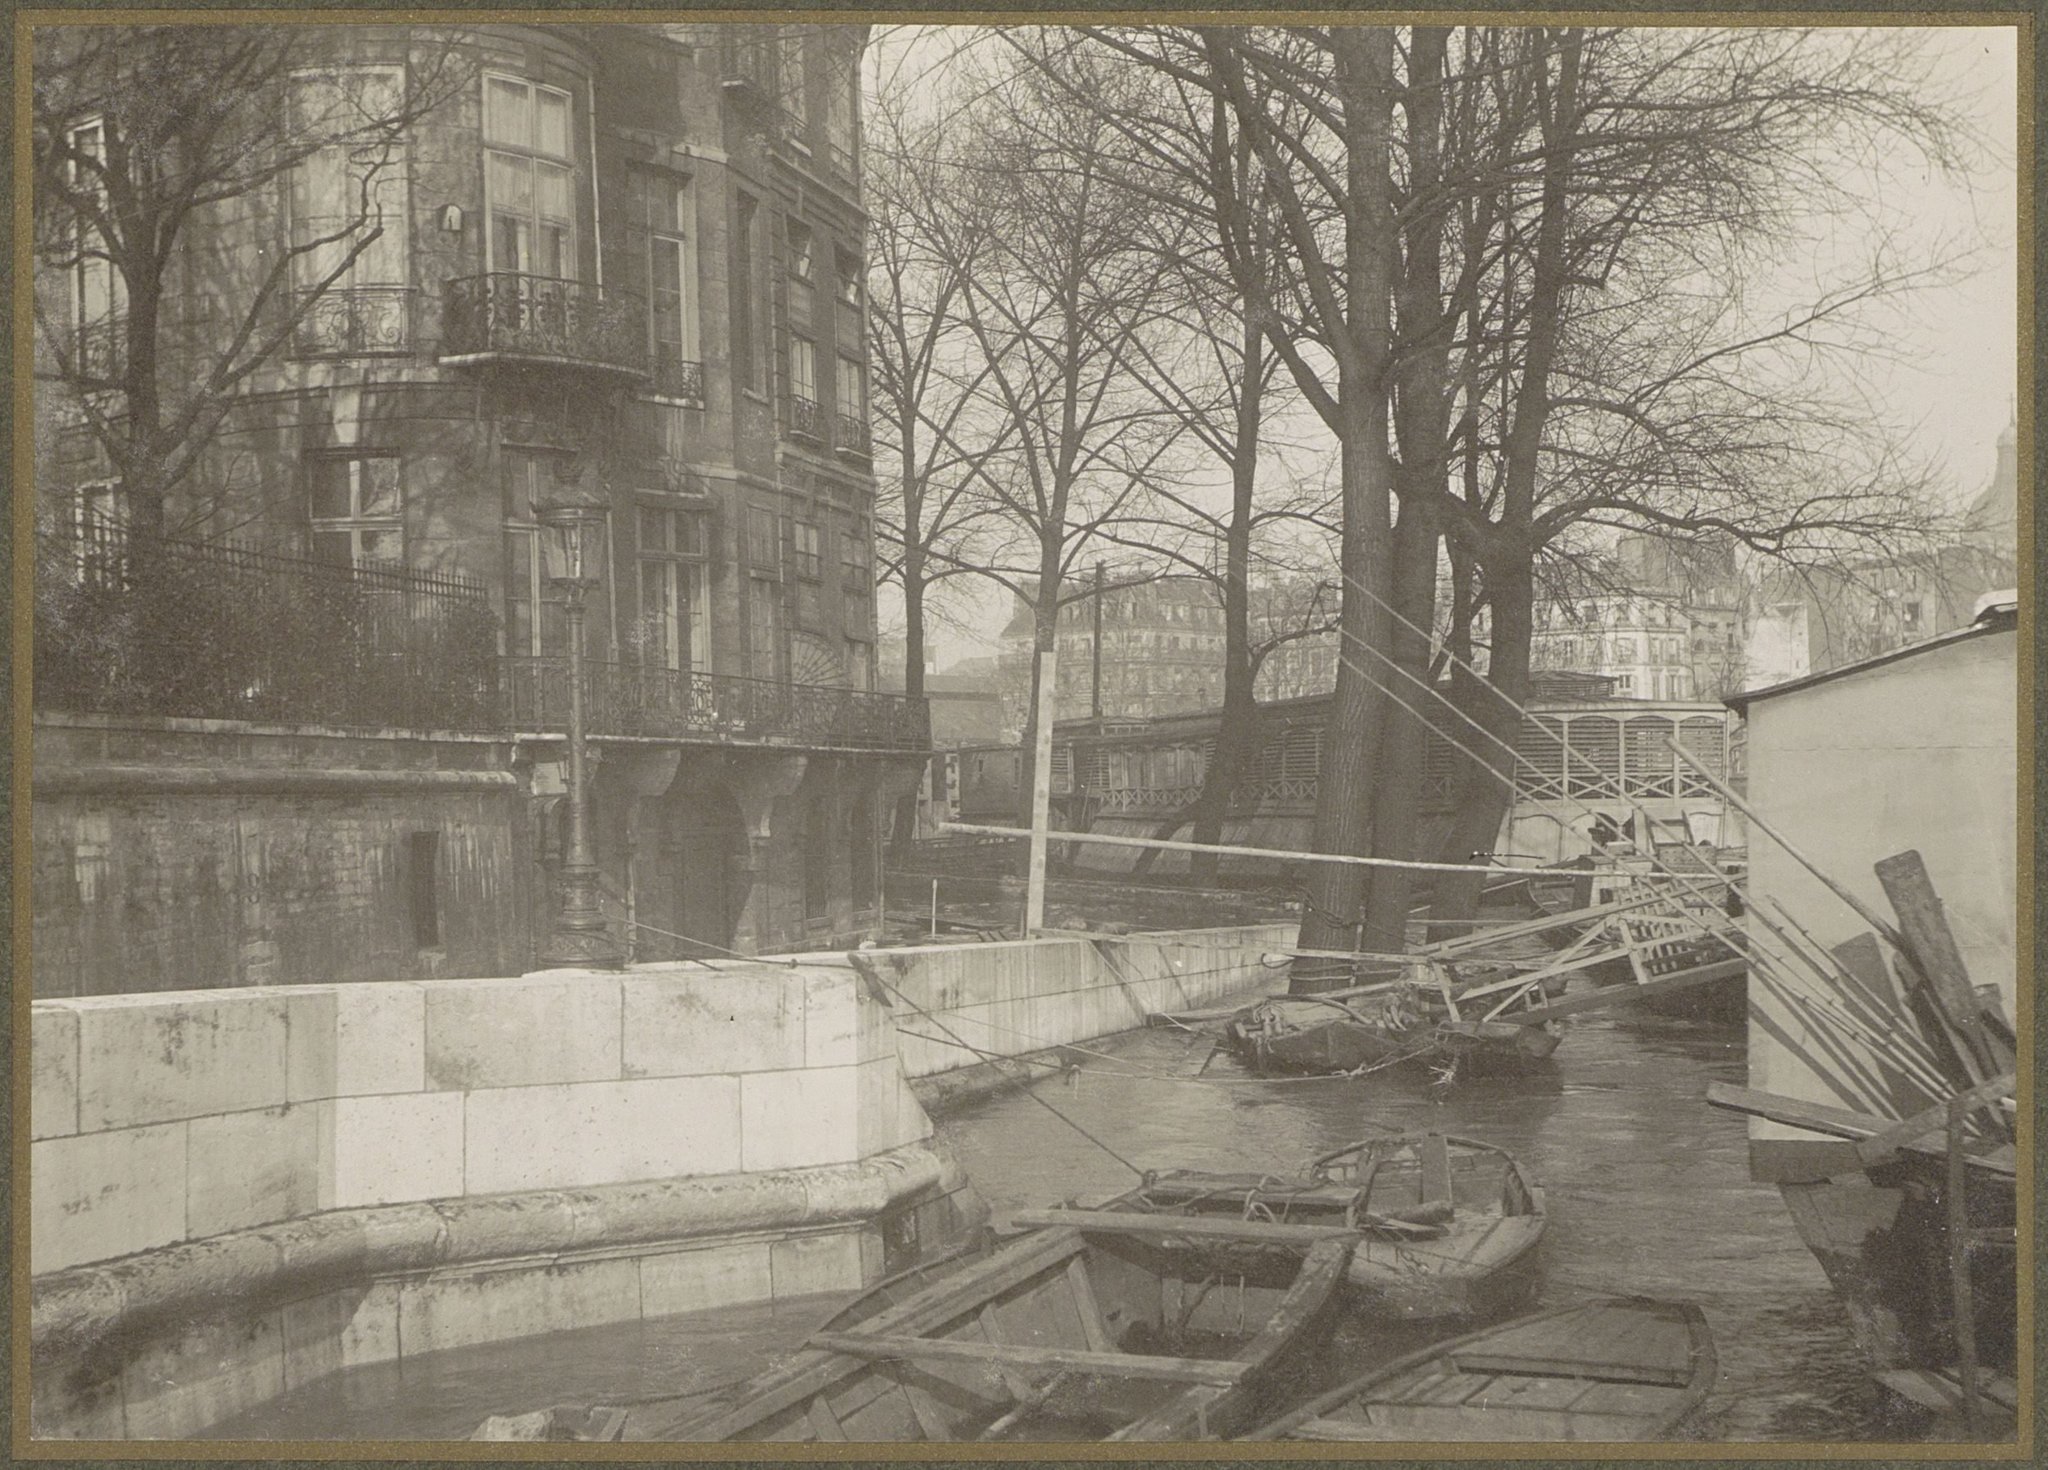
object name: photograph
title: Boten langs een kade tijdens de overstroming van Parijs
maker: g. dangereux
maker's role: fotograaf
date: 1901-1910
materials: photographic support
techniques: matte daylight collodion silver print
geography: paris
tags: flood (+ landscape with figures, staffage), rowing-boat, canoe, etc., paris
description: Onderdeel van fotoalbum overstroming Parijs en voorsteden 1910.